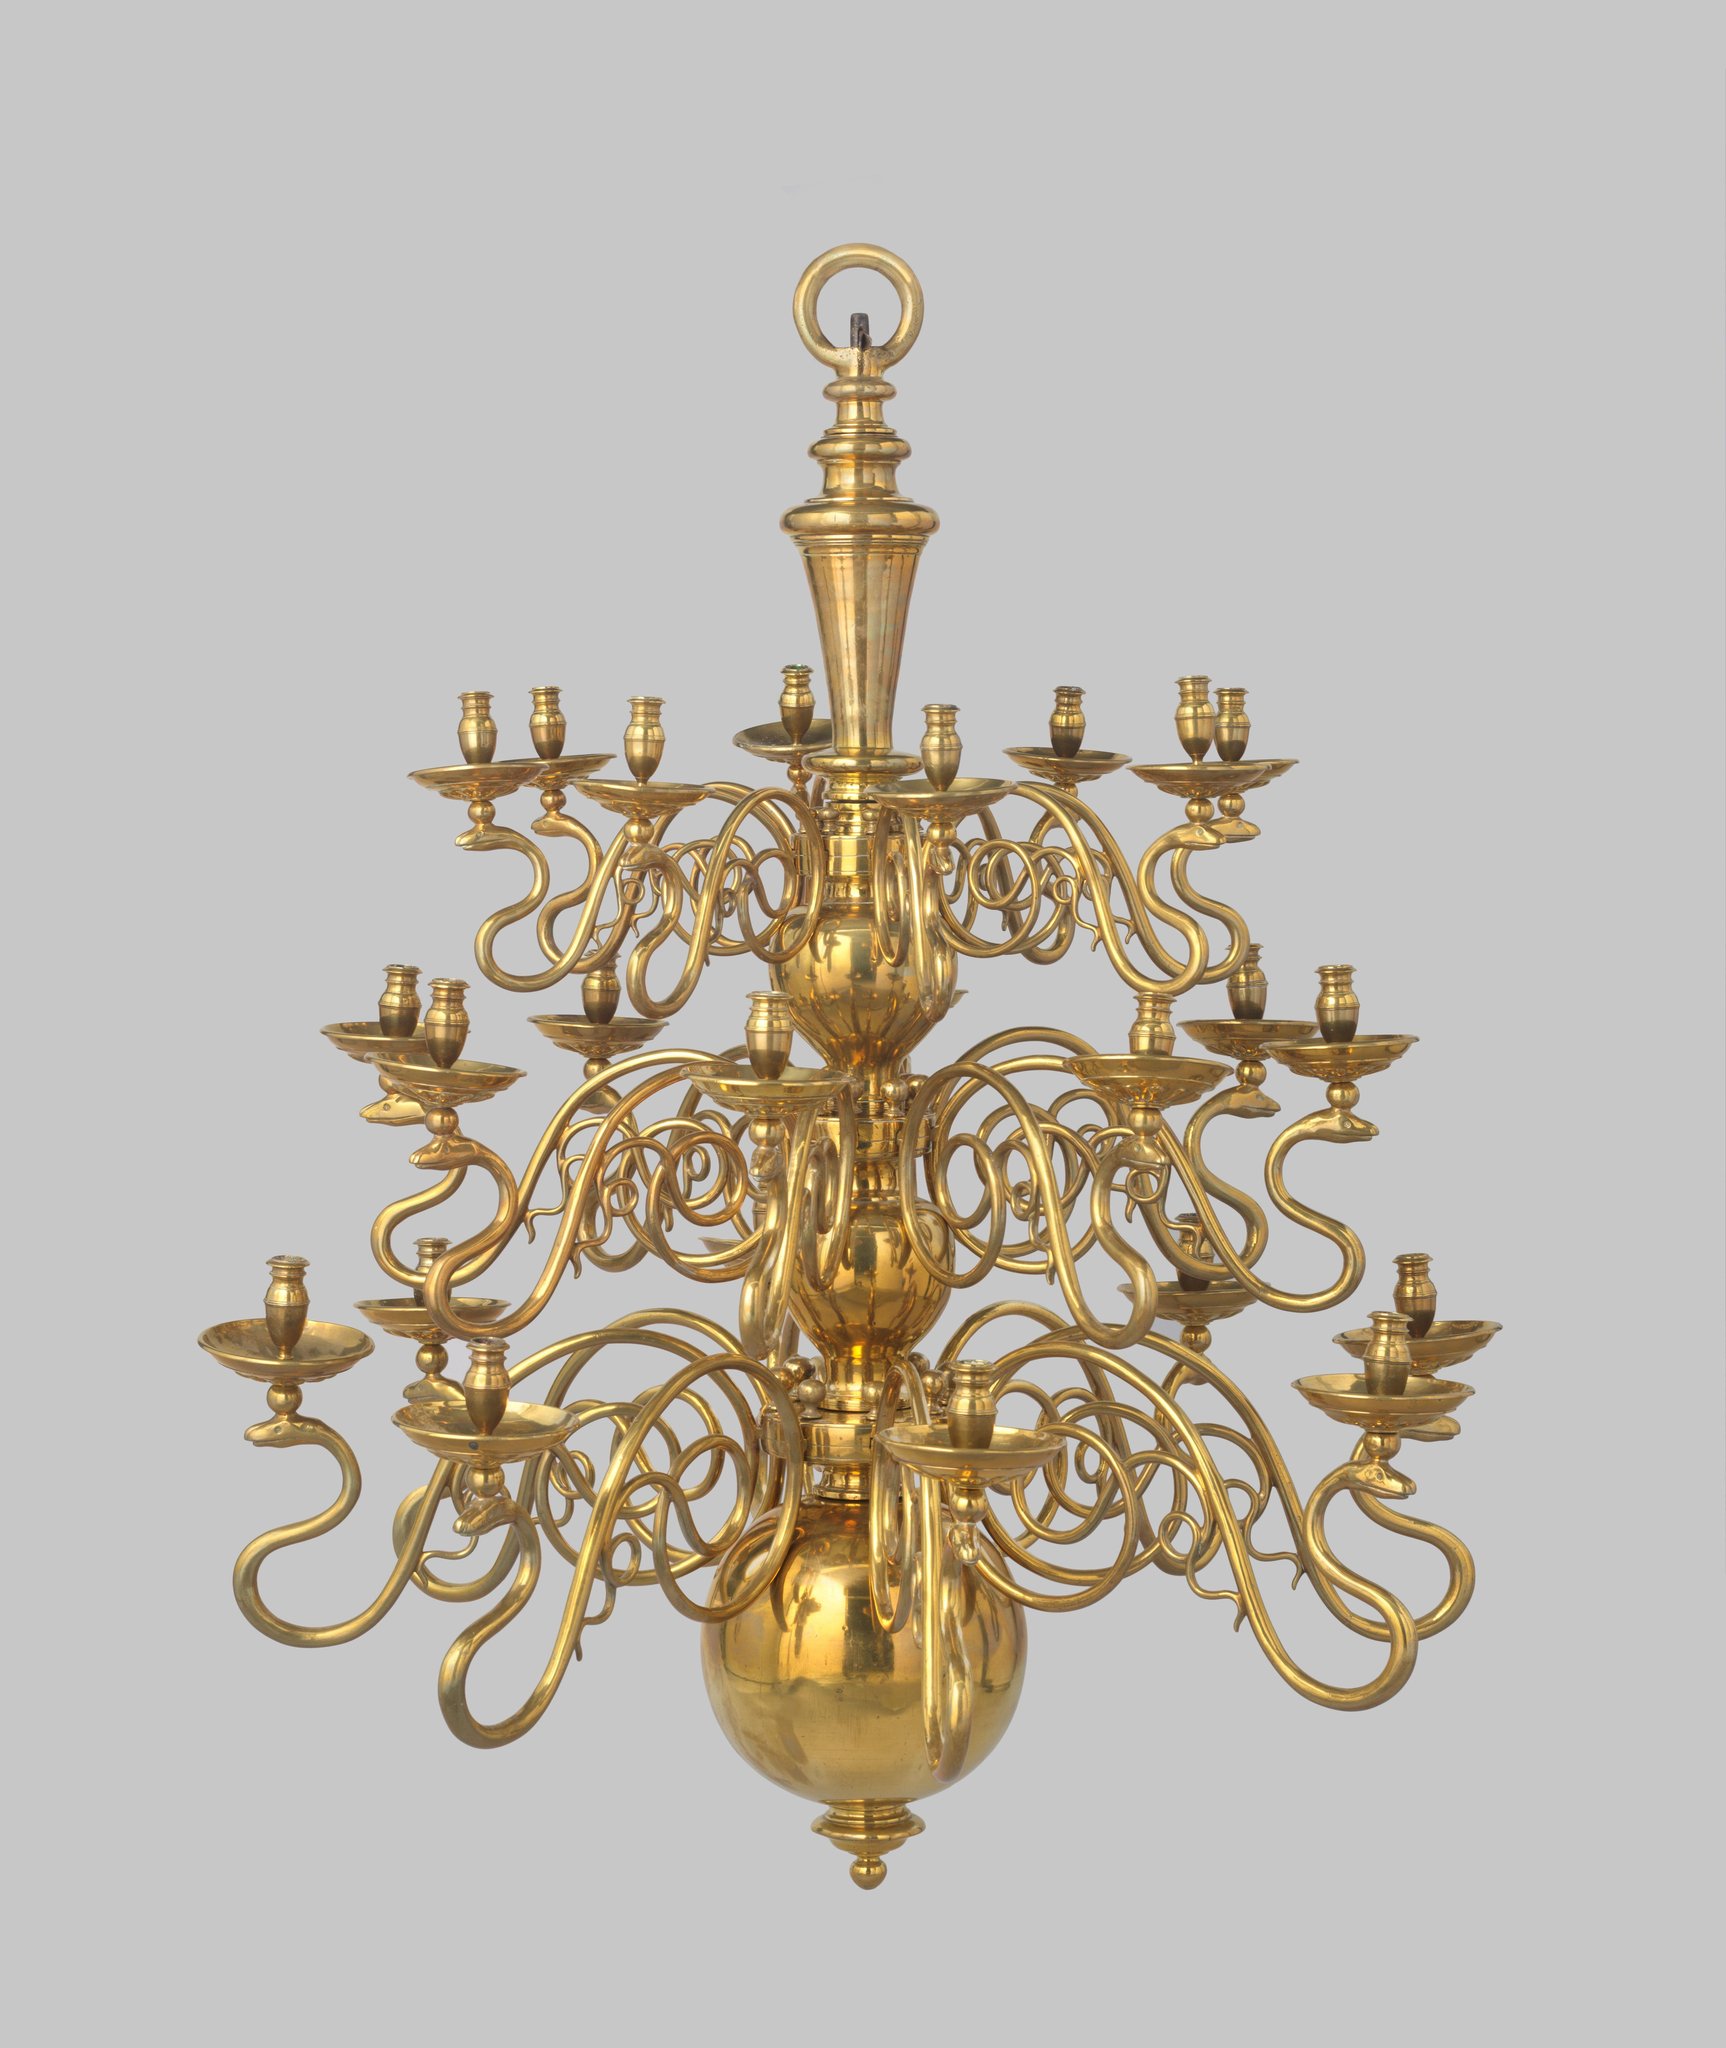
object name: chandelier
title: Arm van een kaarsenkroon in drie hoogten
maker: Anonymous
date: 1625-1650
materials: brass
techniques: screwed, turning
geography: northern netherlands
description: De arm is aan de stamzijde voorzien van een nok, waarin een gat is aangebracht om ze met een pin in de standringen te kunnen vastzetten. De S-vormige arm heeft de gedaante van een slang met een naar de stamzijde gekronkelde staart en naar buiten toe een opgeheven kop met daarop een ronde knop, waarin het van een schroefdraad voorziene gat is aangebracht ter bevestiging van de kaarsenhouders met de vetvangers. De arm is met behulp van hetzelfde model gegoten als de overige armen van de krans. De ronde kaarsenhouder is vaasvormig met een geprofileerde rib. Bovenaan heeft zij twee holronde profileringen, en een uitkragende rand en onderaan een uit twee holronde profileringen bestaande voet. De voet loopt uit in een zich verjongend schroefeind met een centergat. De bolle vetvanger is aan de bovenkant glad en heeft aan de onderkant visblaasachtige godrons en een rib. De vetvanger is met behulp van hetzelfde model gegoten als de overige vetvangers van de krans. De pinnen zijn met bolle knoppen versierd. Dit is de derde arm van de onderste standring, genummerd op de nok met het cijfer III.